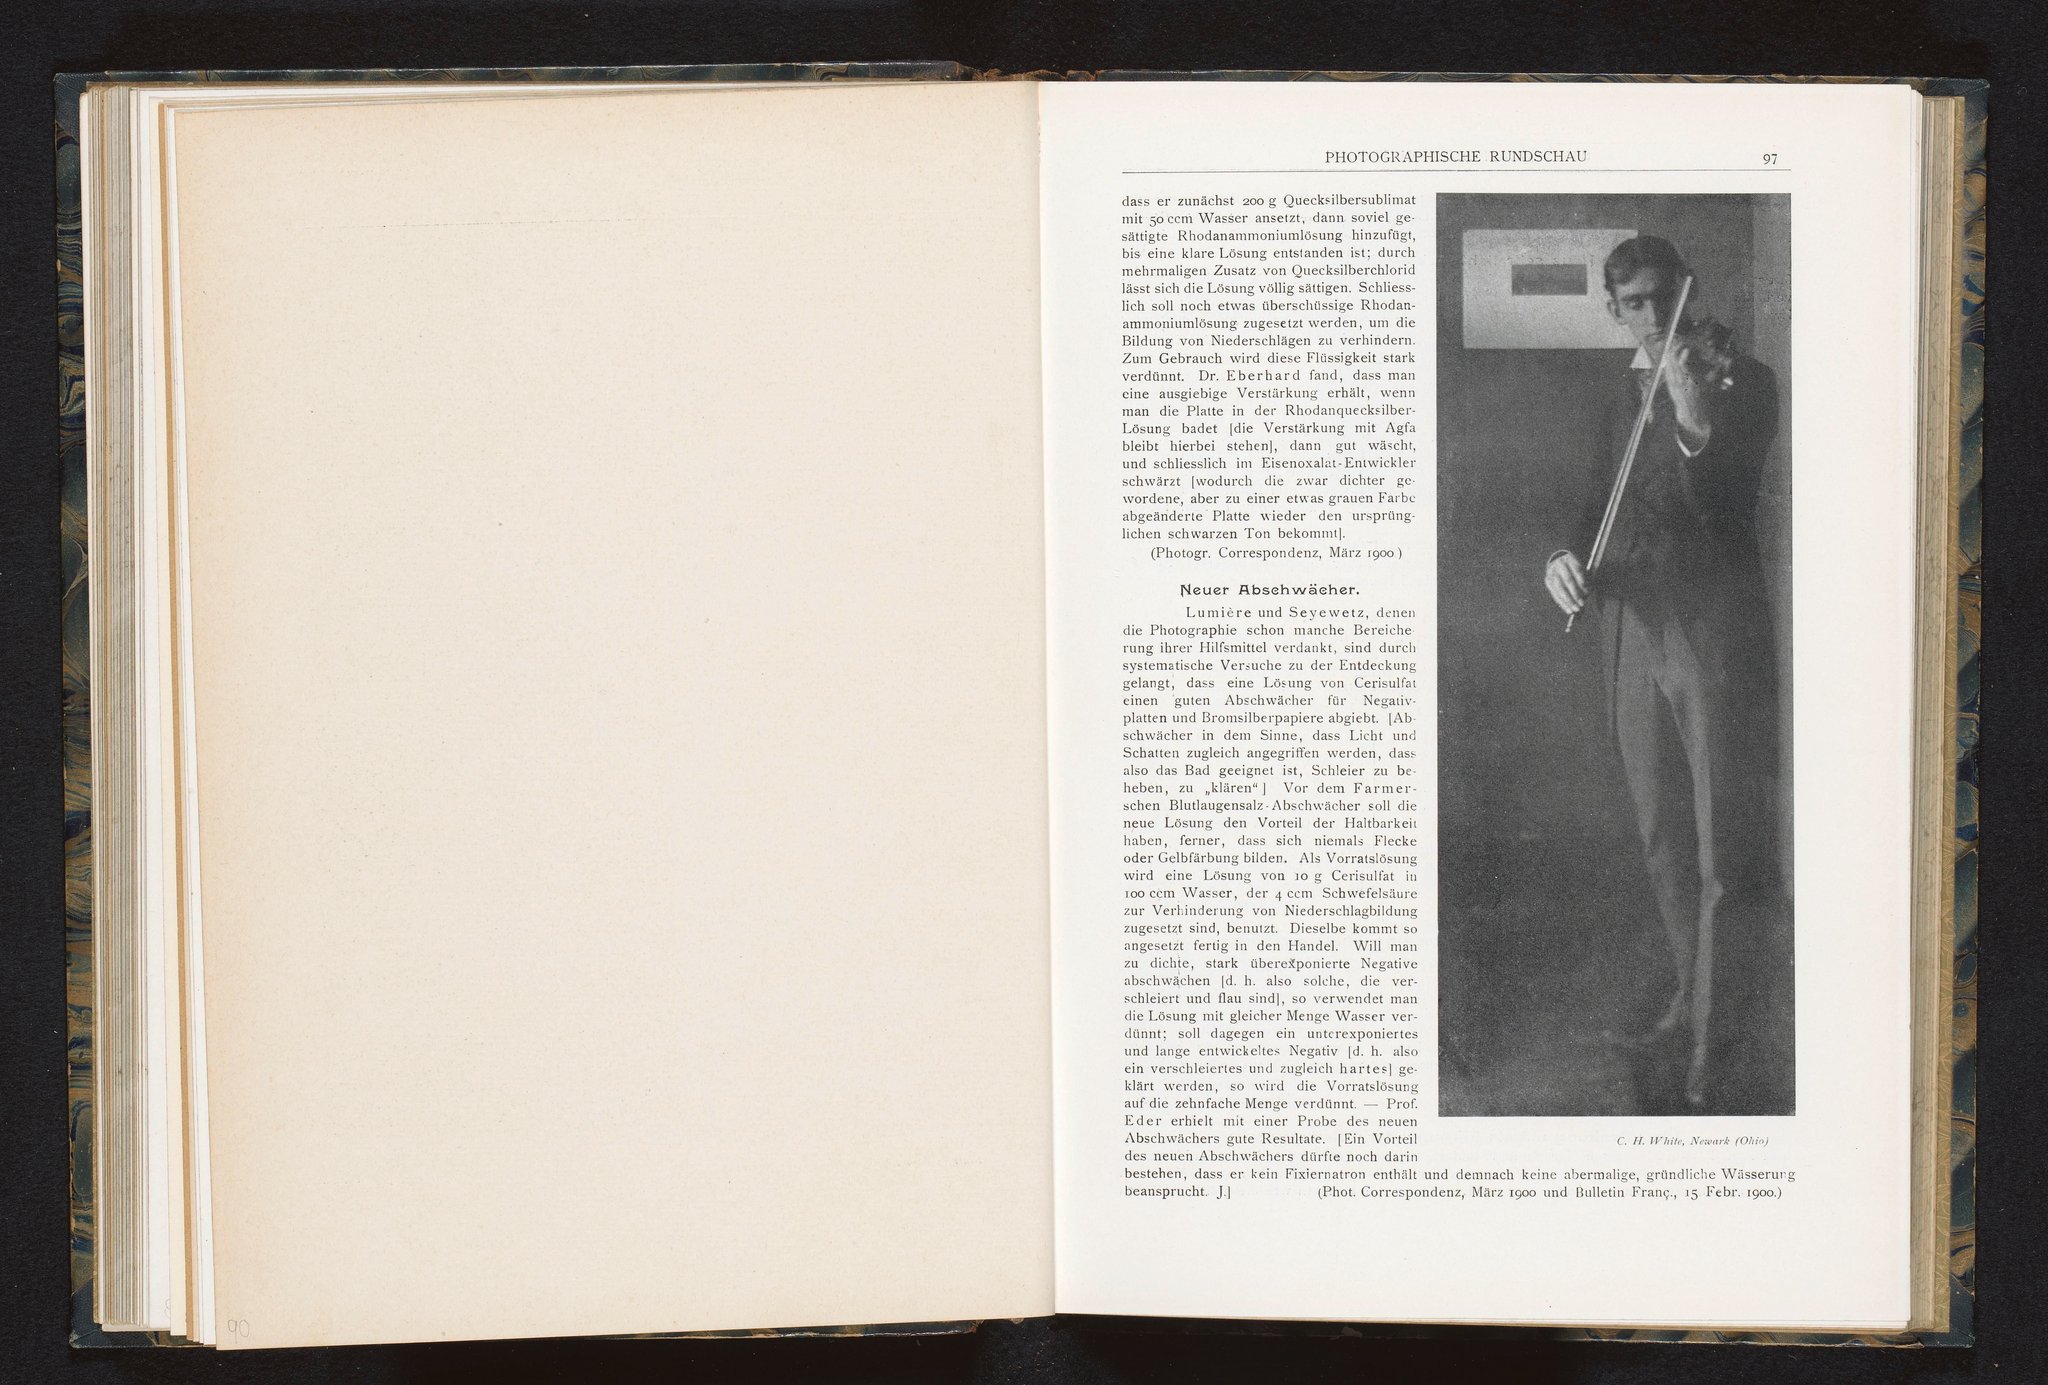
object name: page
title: Portret van een onbekende man die viool speelt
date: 1895-1900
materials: paper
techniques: autotype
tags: violin, fiddle, anonymous historical person portrayed